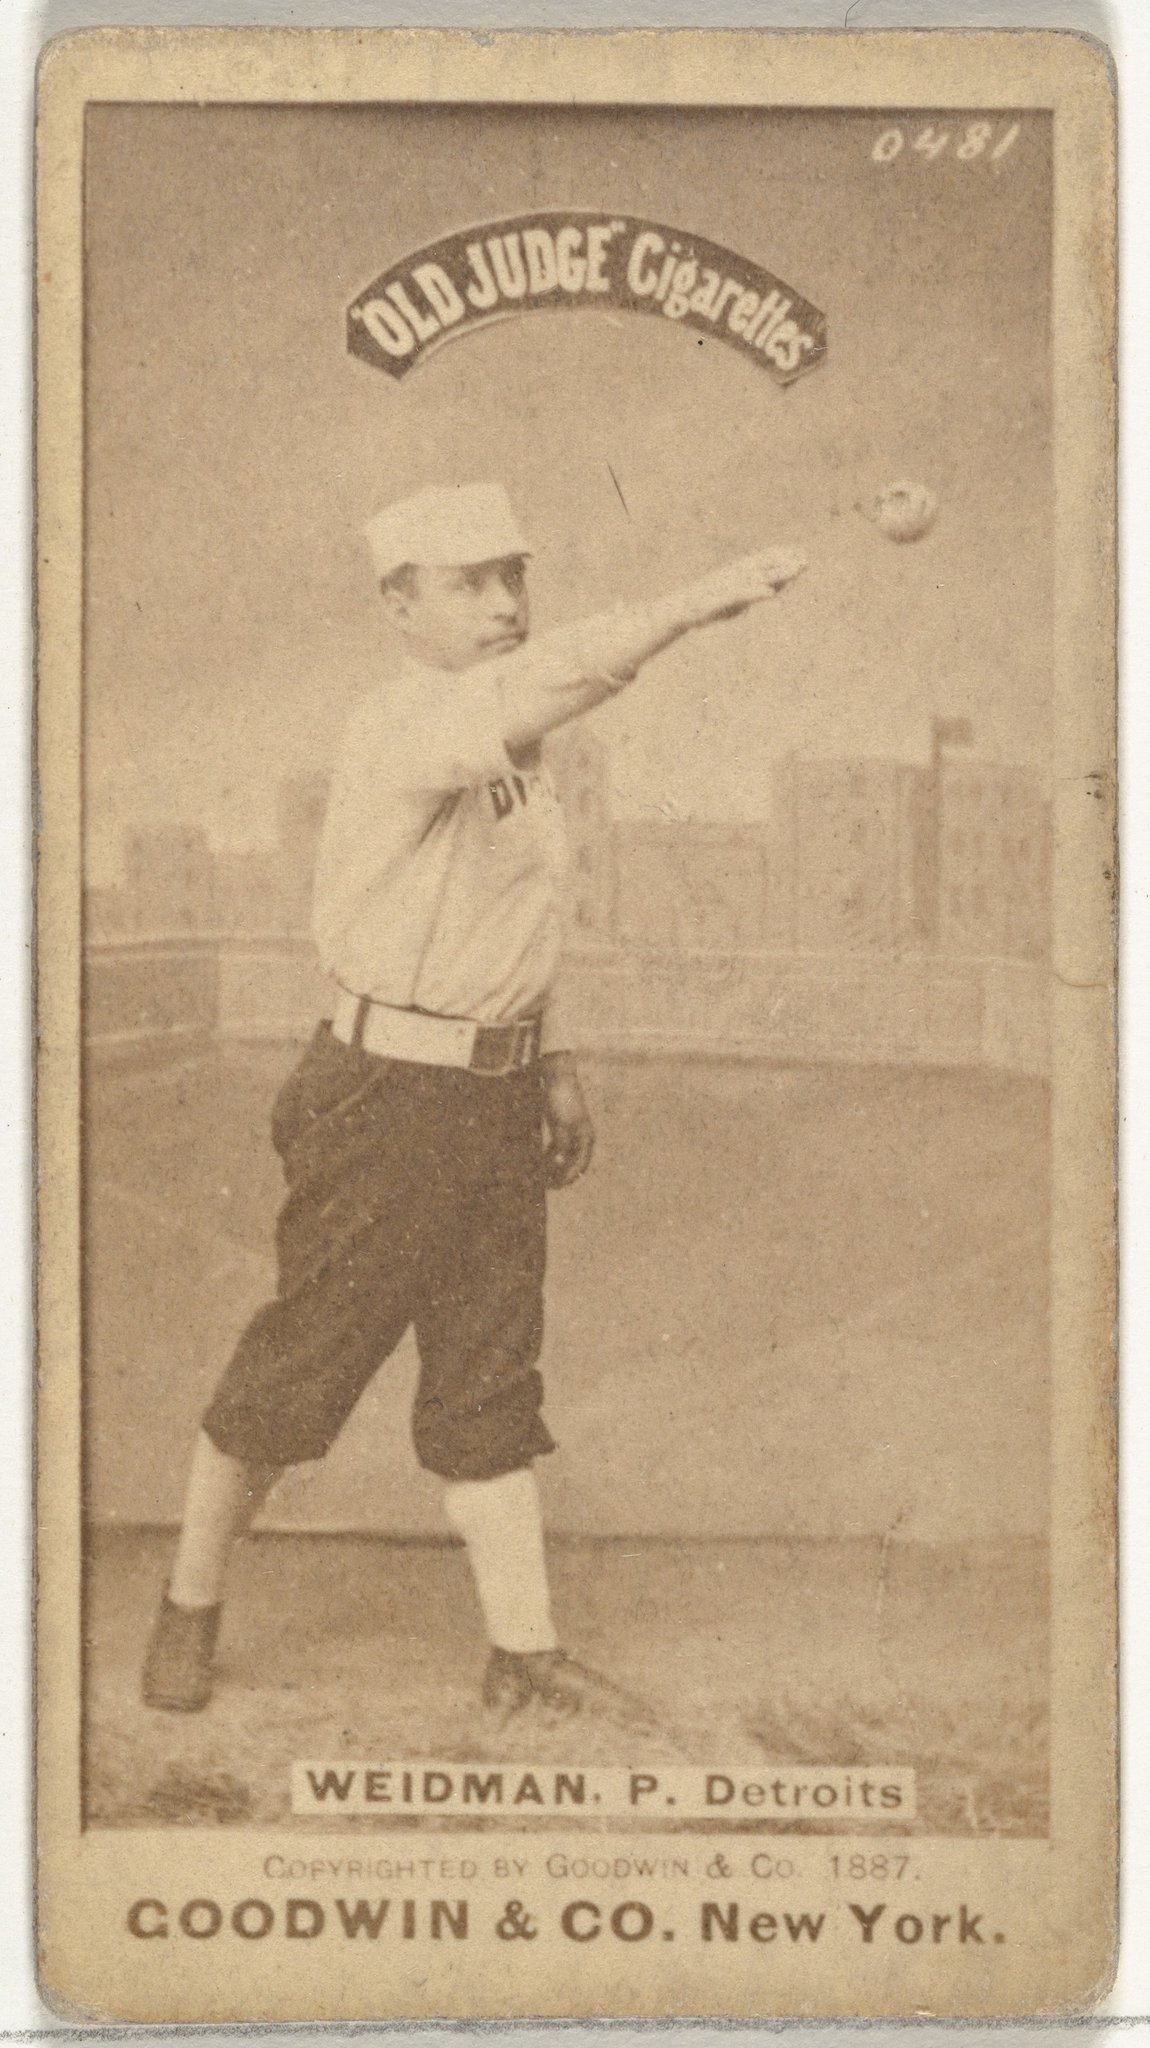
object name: baseball card, photograph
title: George Edward "Stump" Wiedman, Pitcher, Detroit Wolverines, from the Old Judge series (N172) for Old Judge Cigarettes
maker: goodwin & company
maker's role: publisher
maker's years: 1850-1950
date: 1887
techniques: albumen silver print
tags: men,portraits,baseball,athletes